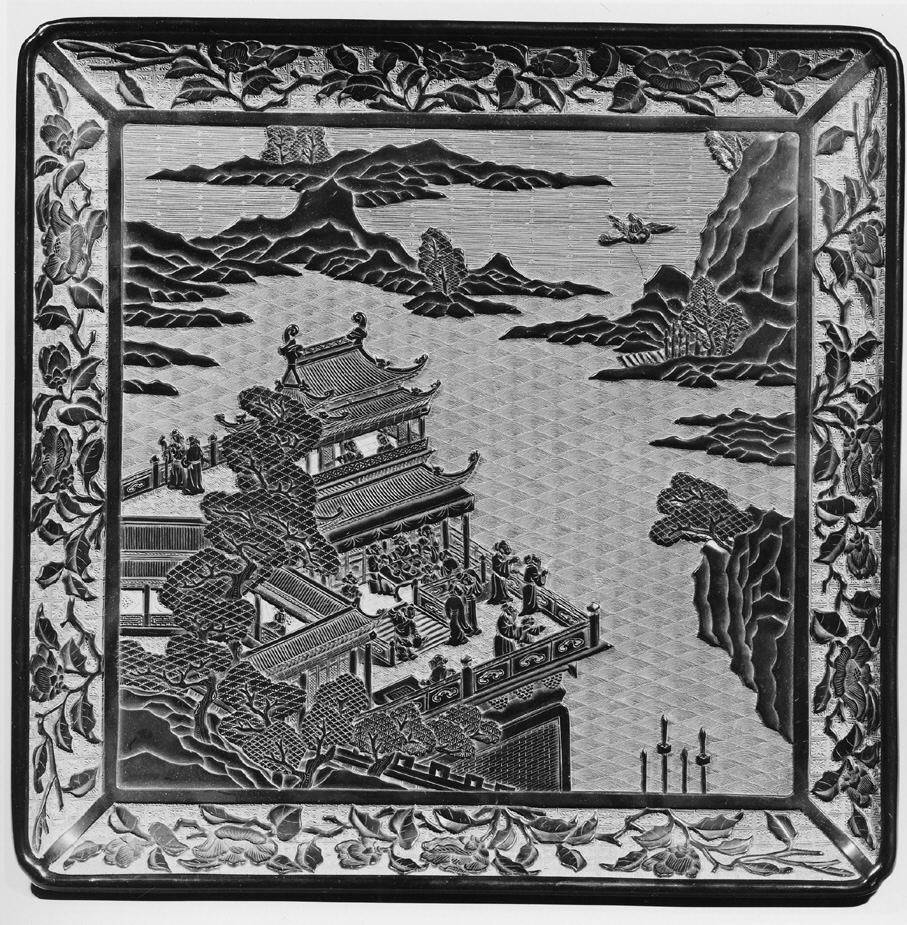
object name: tray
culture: chinese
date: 1701-1800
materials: lacquer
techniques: carving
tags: pavilions